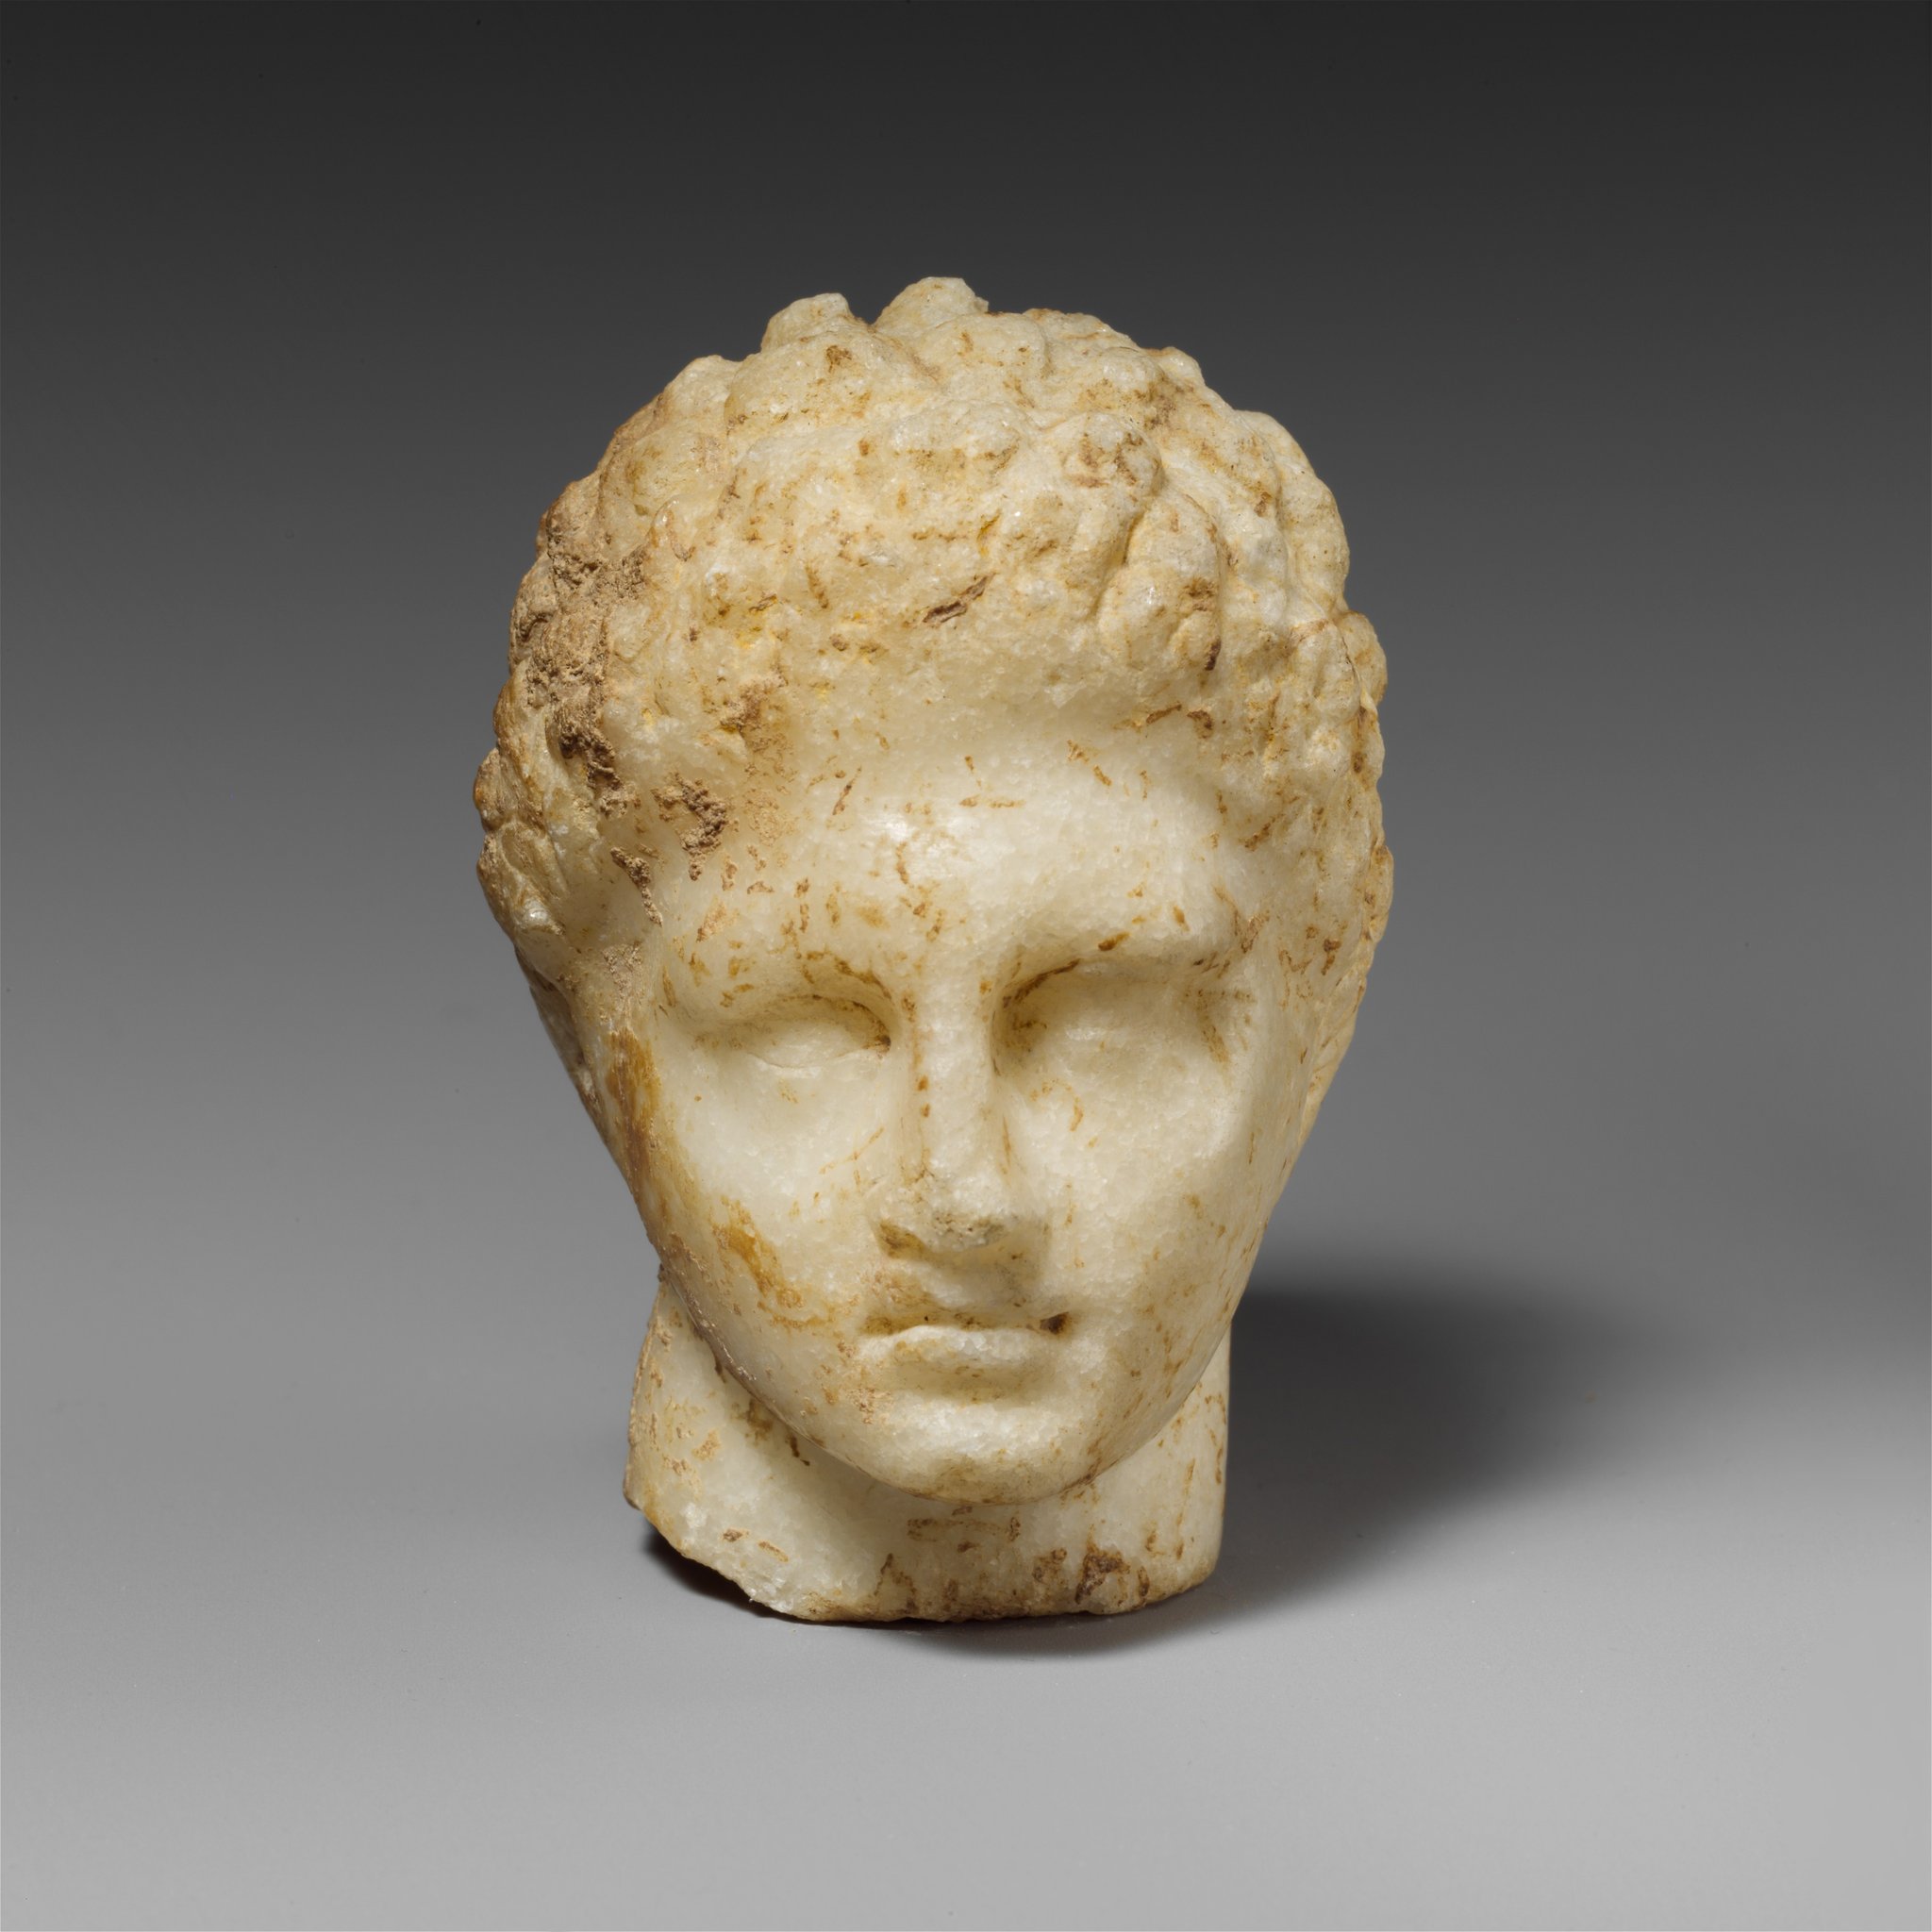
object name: head of a youth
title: Marble head of a youth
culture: greek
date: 400-301 BCE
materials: marble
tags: heads,men